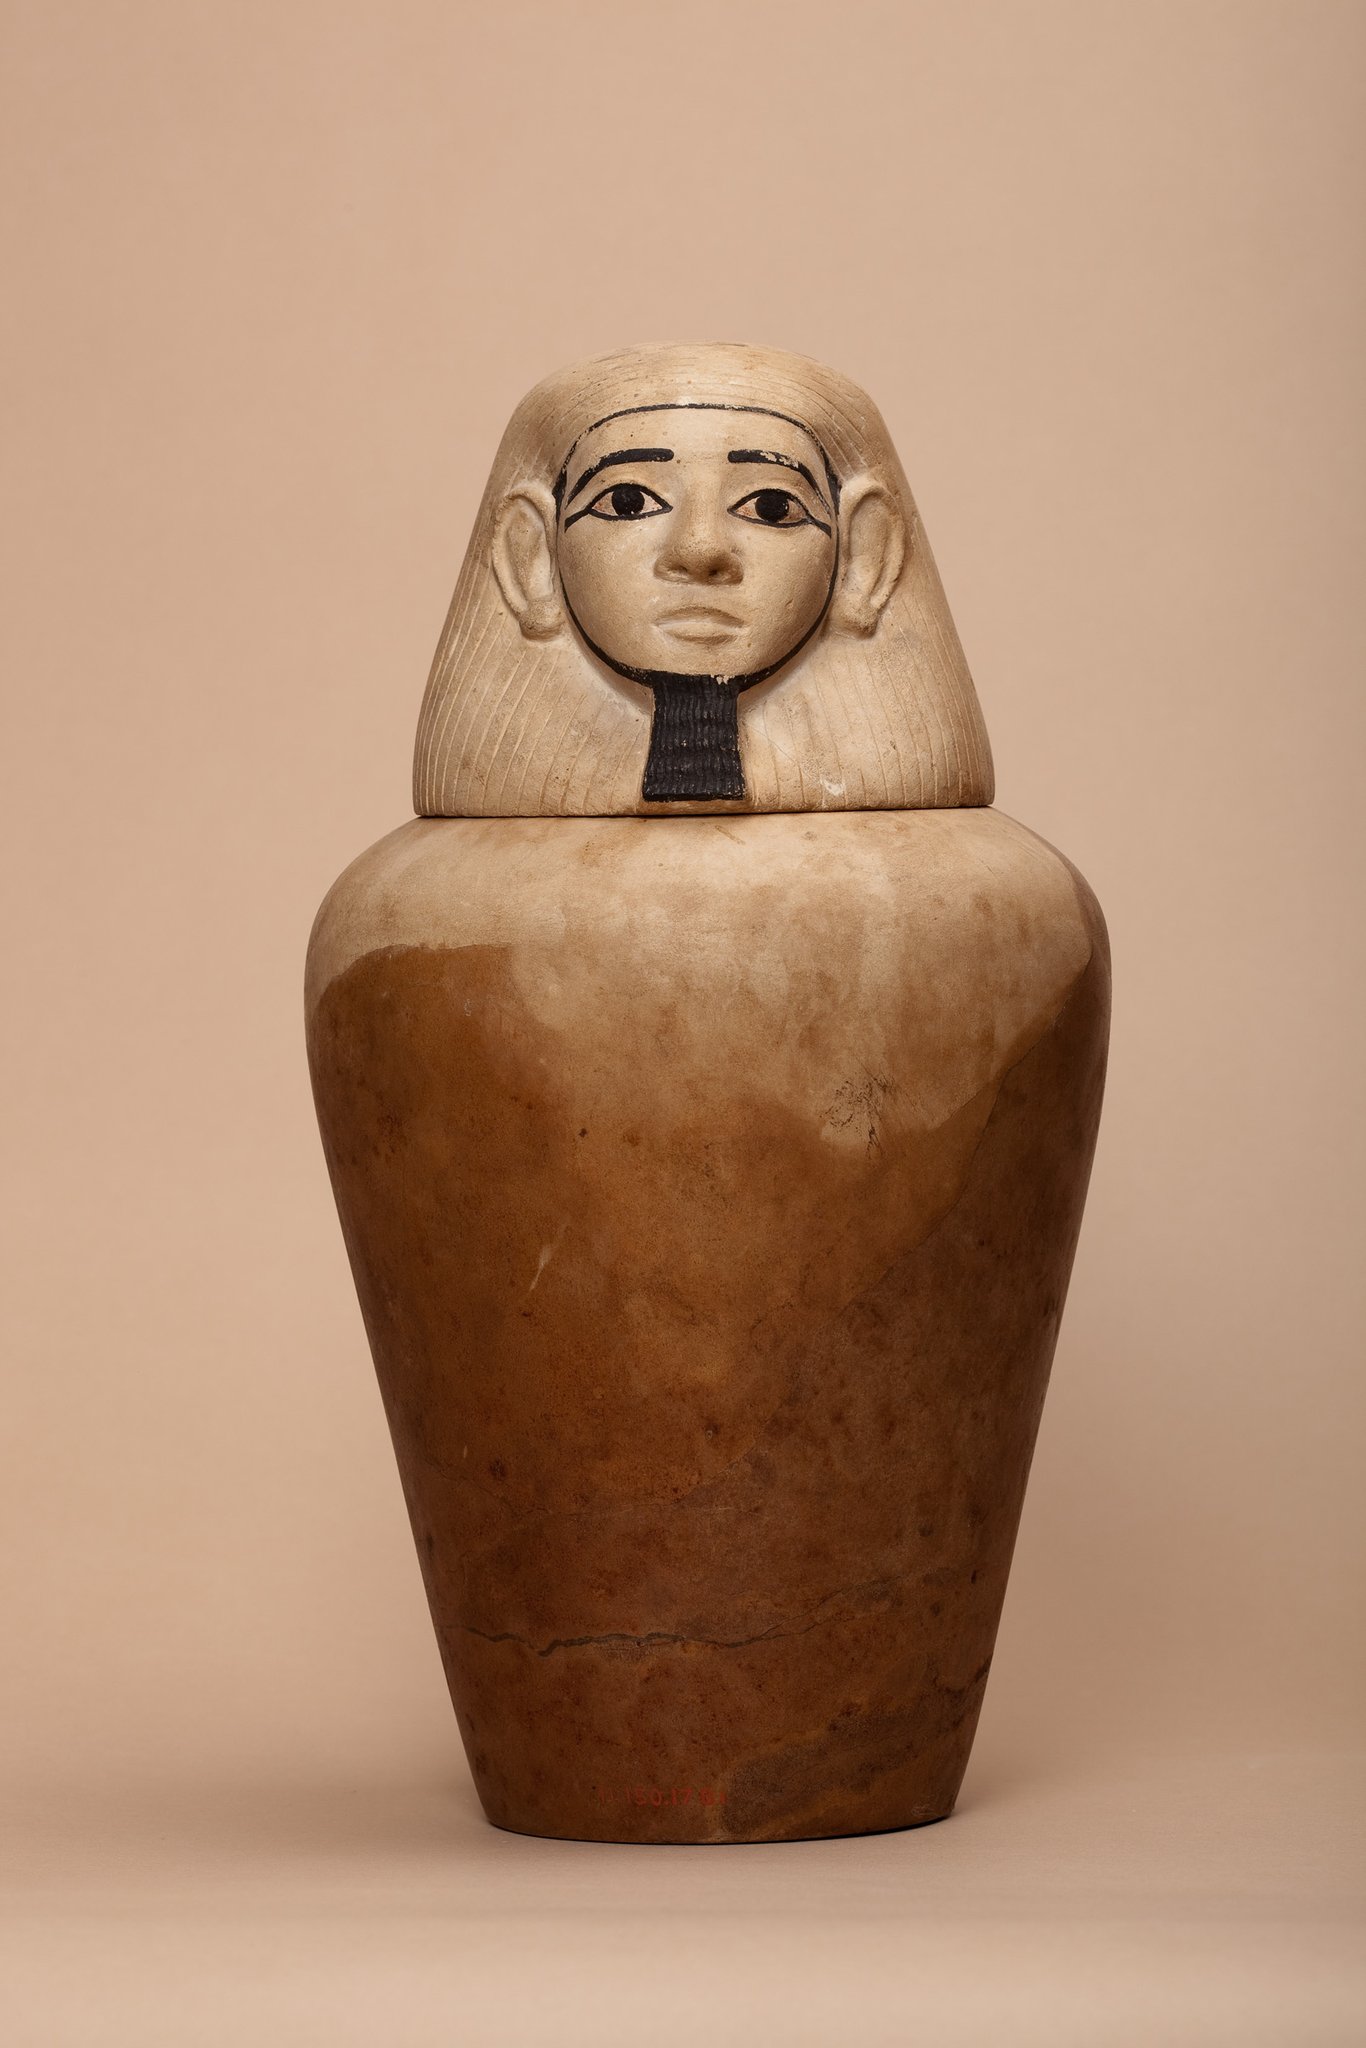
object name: canopic jar, nephthys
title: Canopic jar of Nephthys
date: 1981-1802 BCE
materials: limestone, linen, paint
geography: egypt